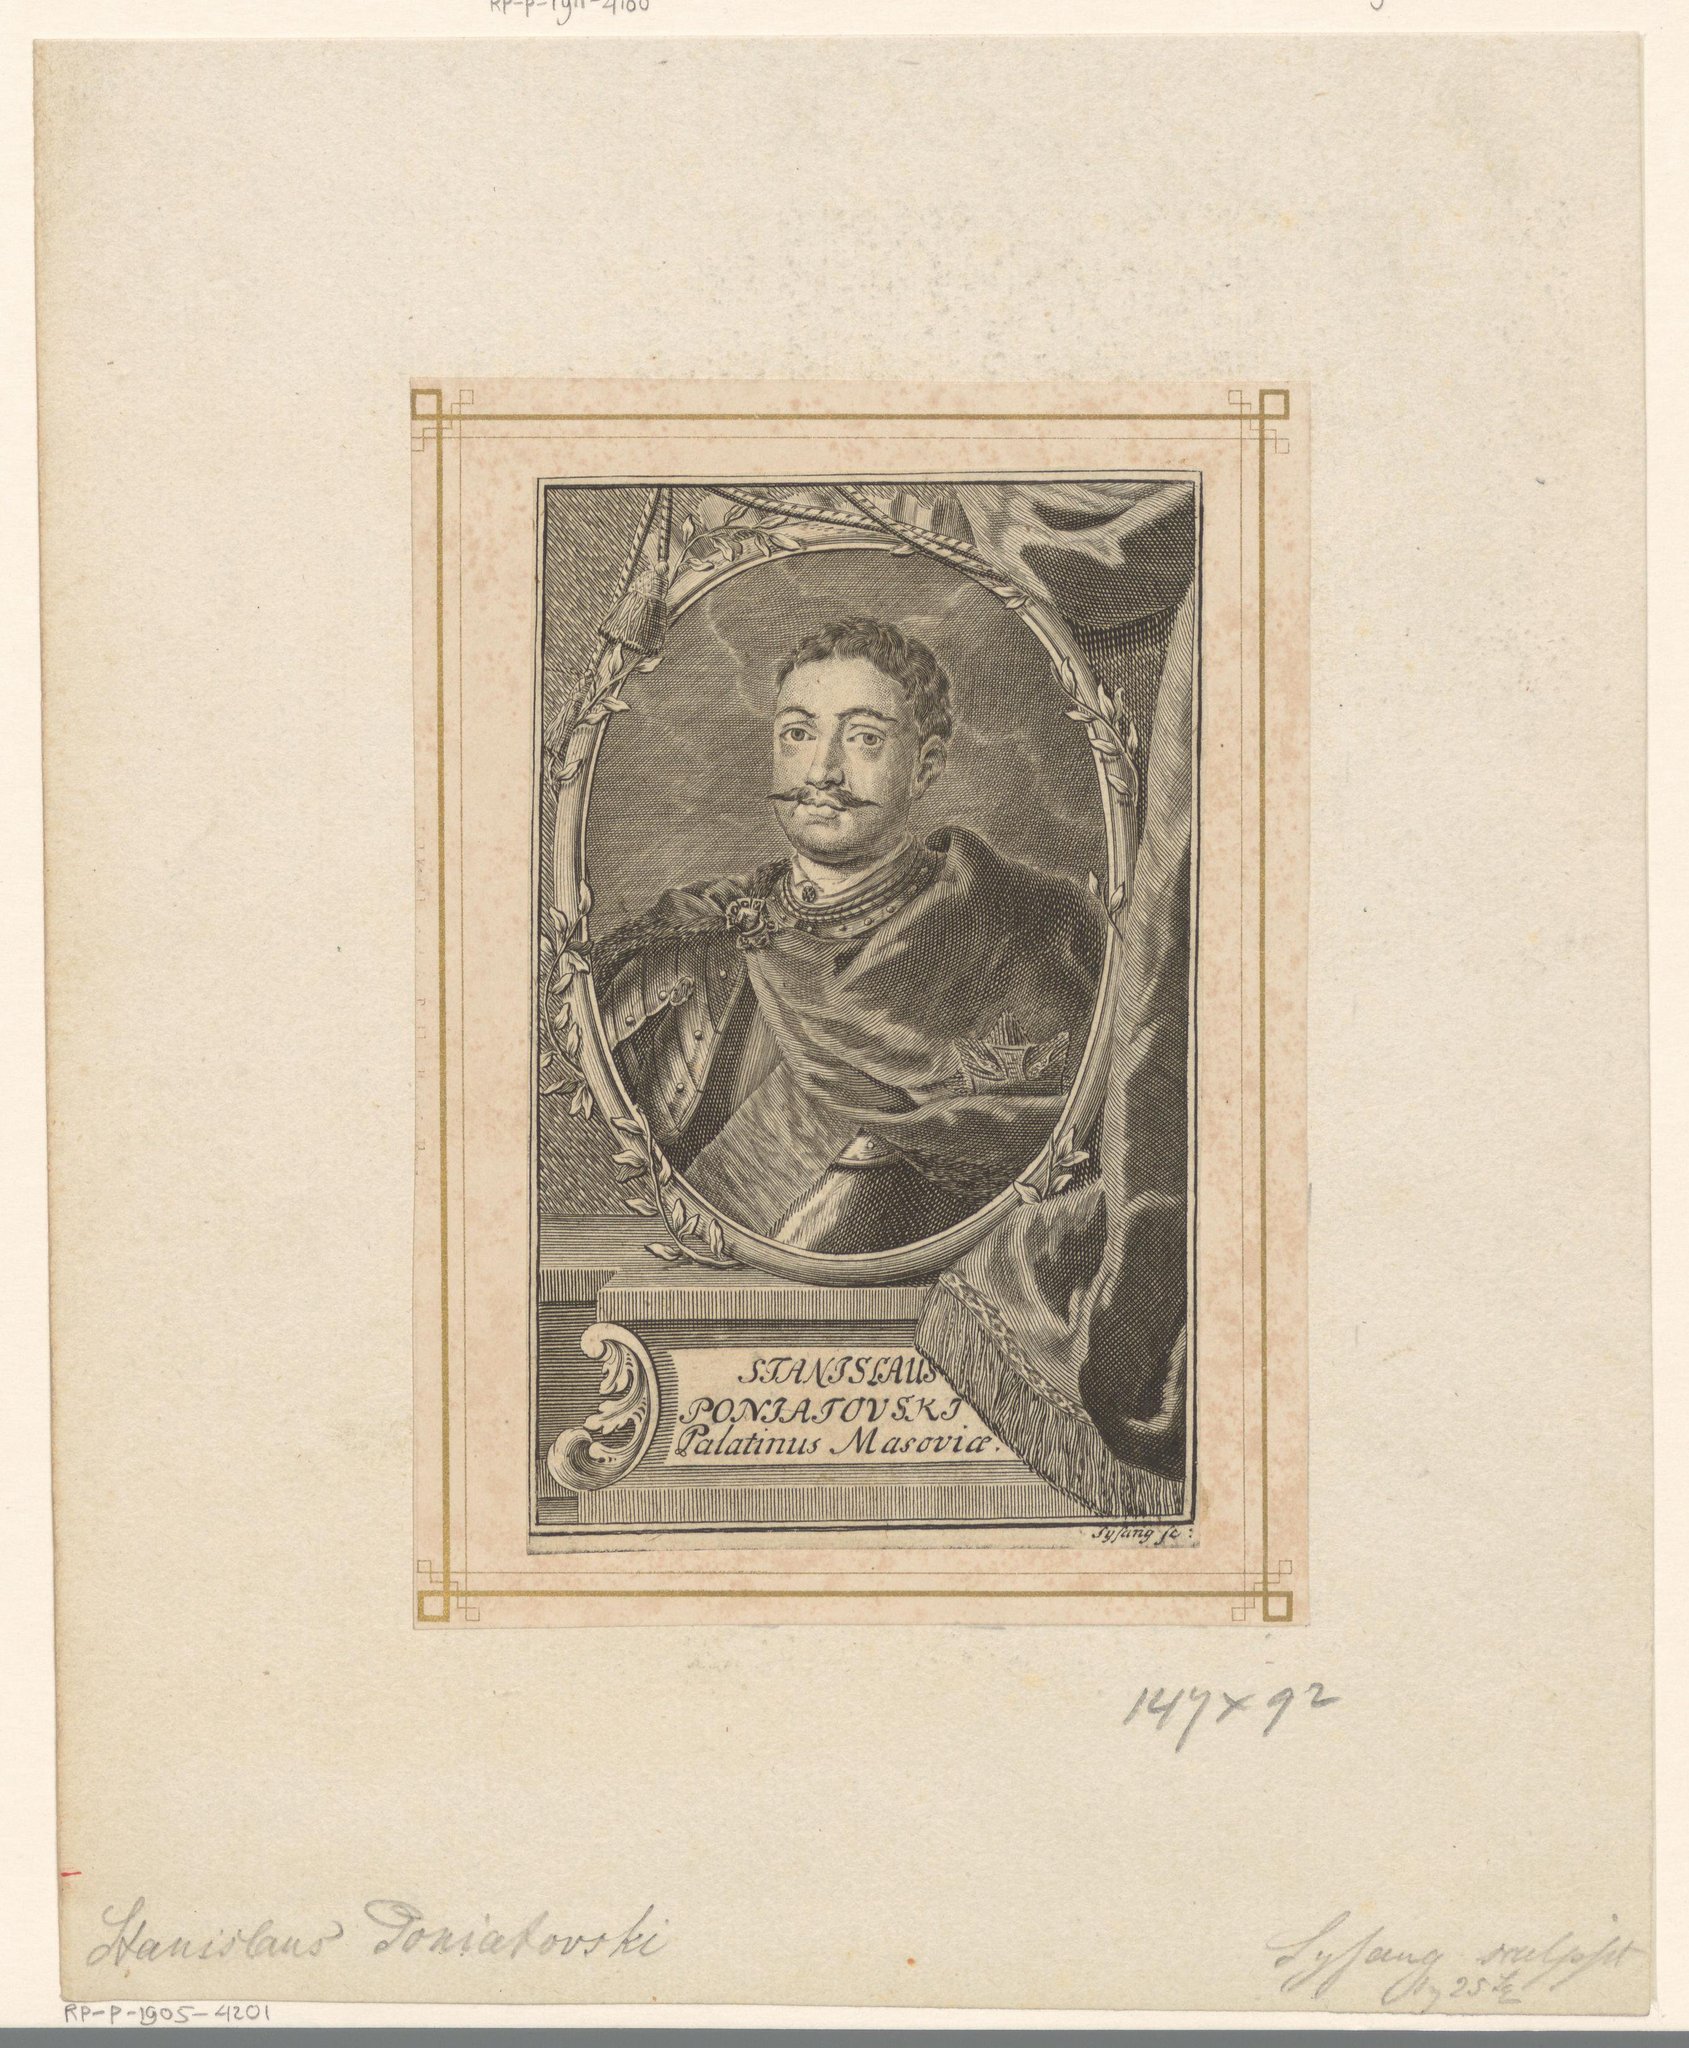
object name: print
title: Portret van Stanisław Ciołek, Graf Poniatowski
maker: johann christoph sysang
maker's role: print maker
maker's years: 1703-1757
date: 1713-1757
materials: paper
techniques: engraving, etching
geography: germany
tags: historical persons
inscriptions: collector's mark: Lugt 2228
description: De prent is gemonteerd op een blad met een gouden ornamentrand in chromolithografie.